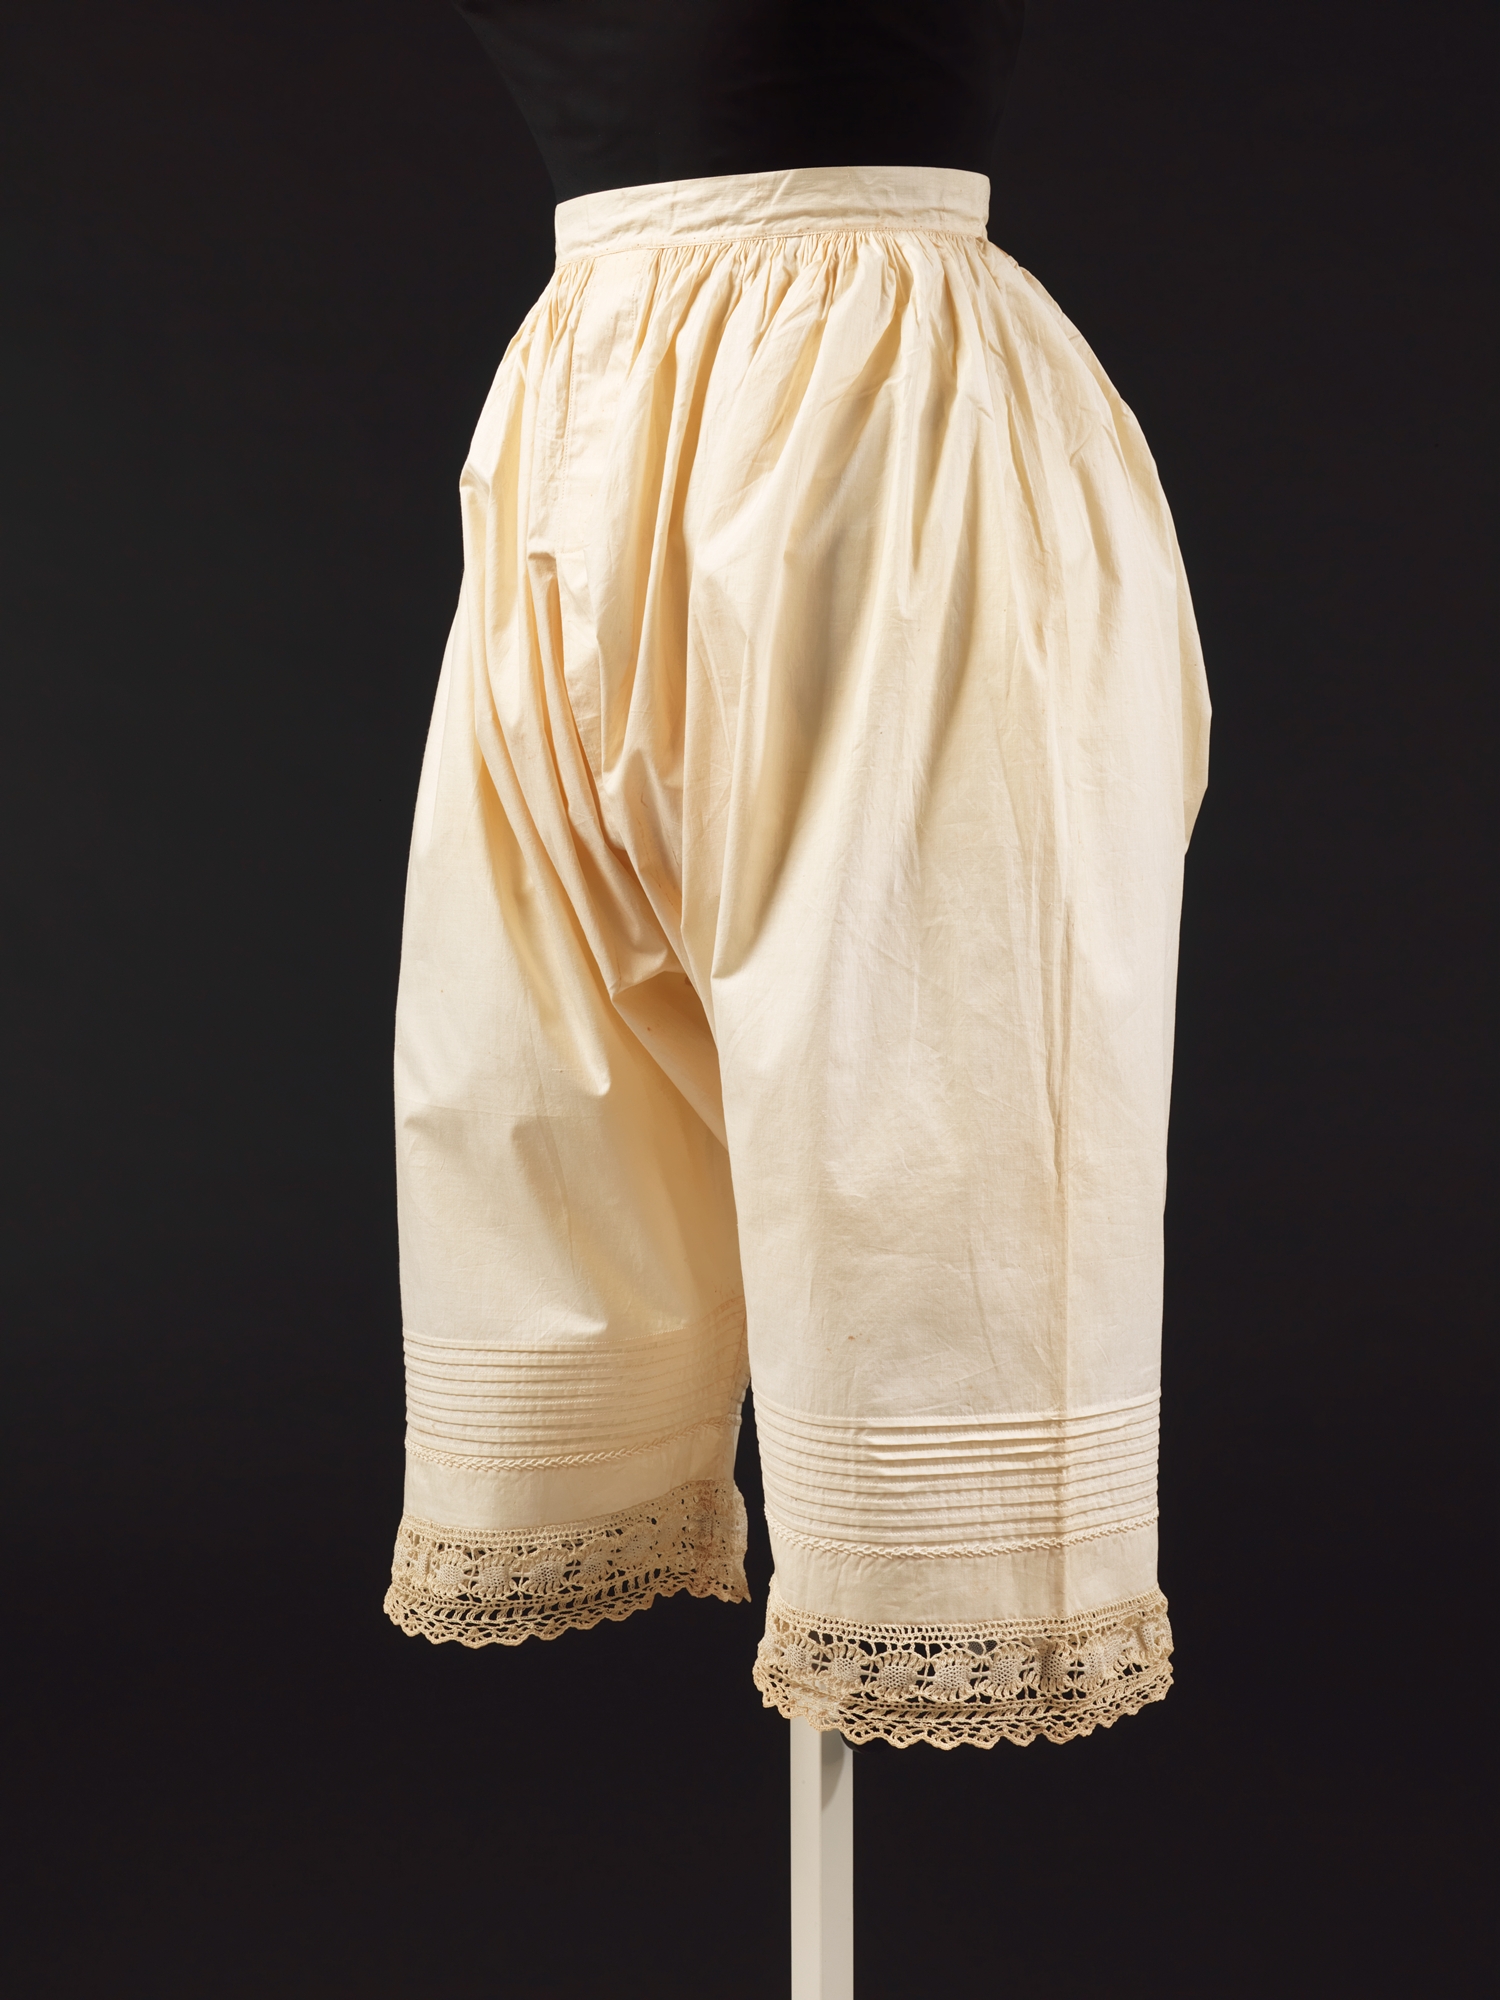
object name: drawer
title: Drawers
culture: american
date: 1876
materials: cotton